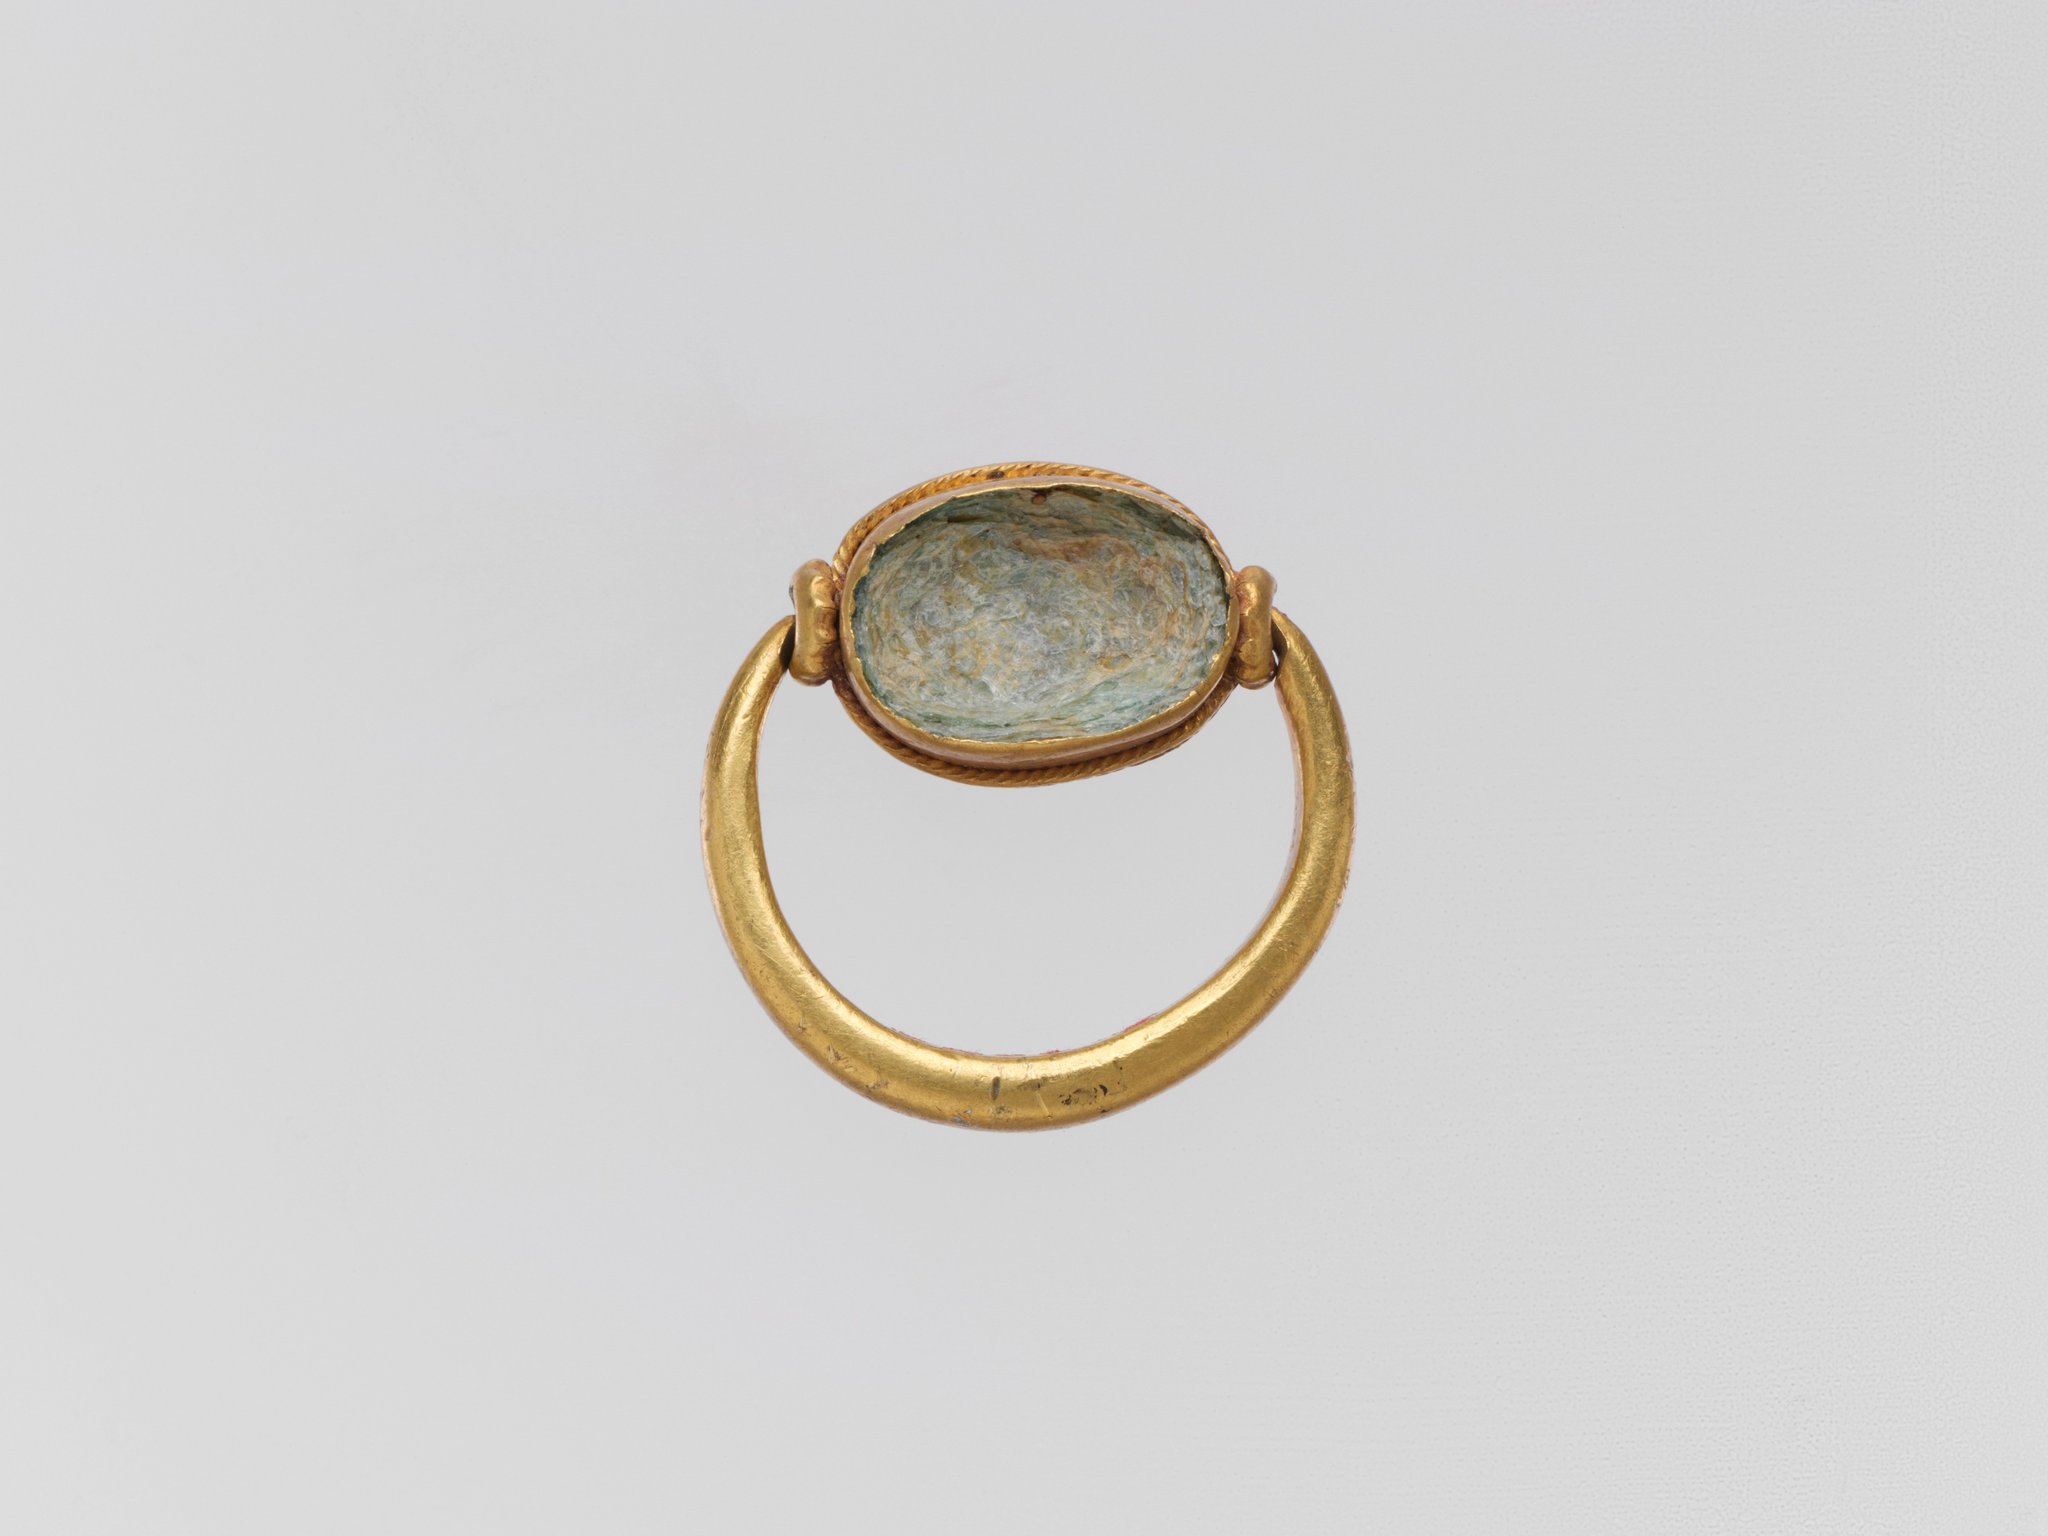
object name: ring with glass paste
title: Gold ring with glass paste ring stone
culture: cypriot or greek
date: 600-401 BCE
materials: glass, gold, paste